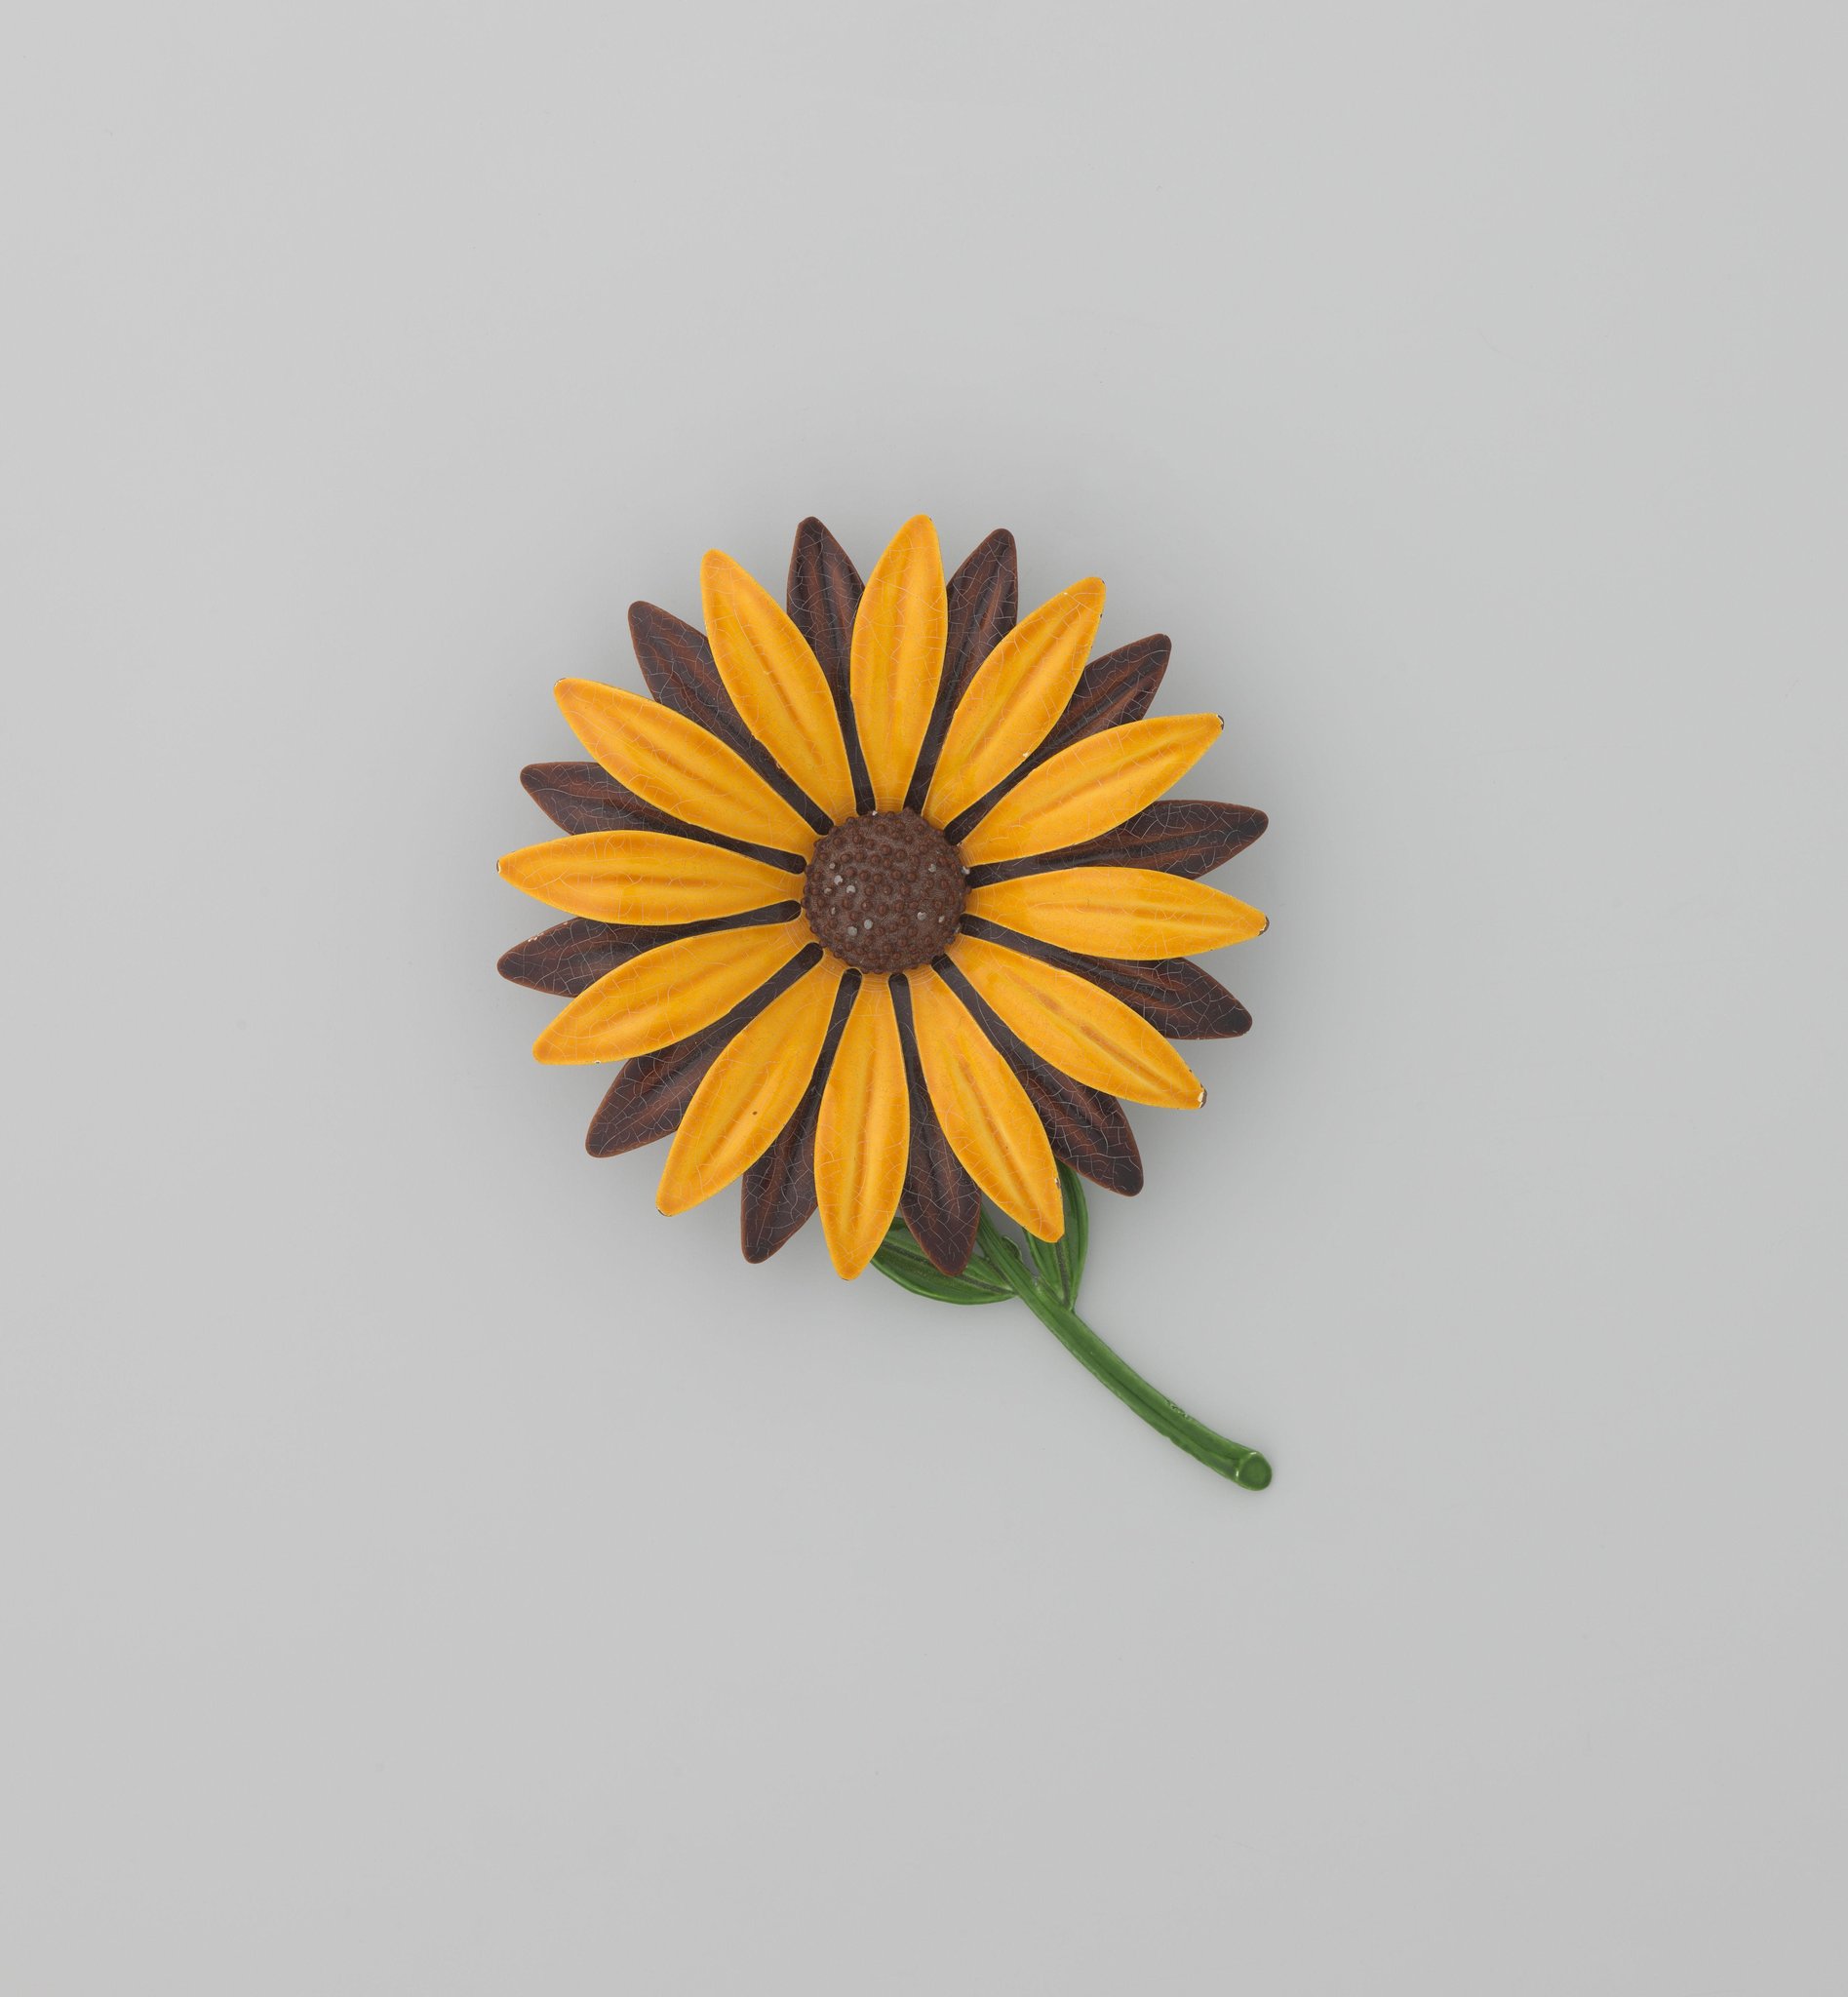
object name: brooch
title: Broche in de vorm van een bloem in geel, bruin en groen geëmailleerd metaal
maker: Anonymous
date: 1950-1970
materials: metal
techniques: enameling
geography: netherlands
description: Het hart van de bloem op een tak is bruin en de bladeren alterneren geel op bruin. De broche is voorzien van een kanonsluiting.